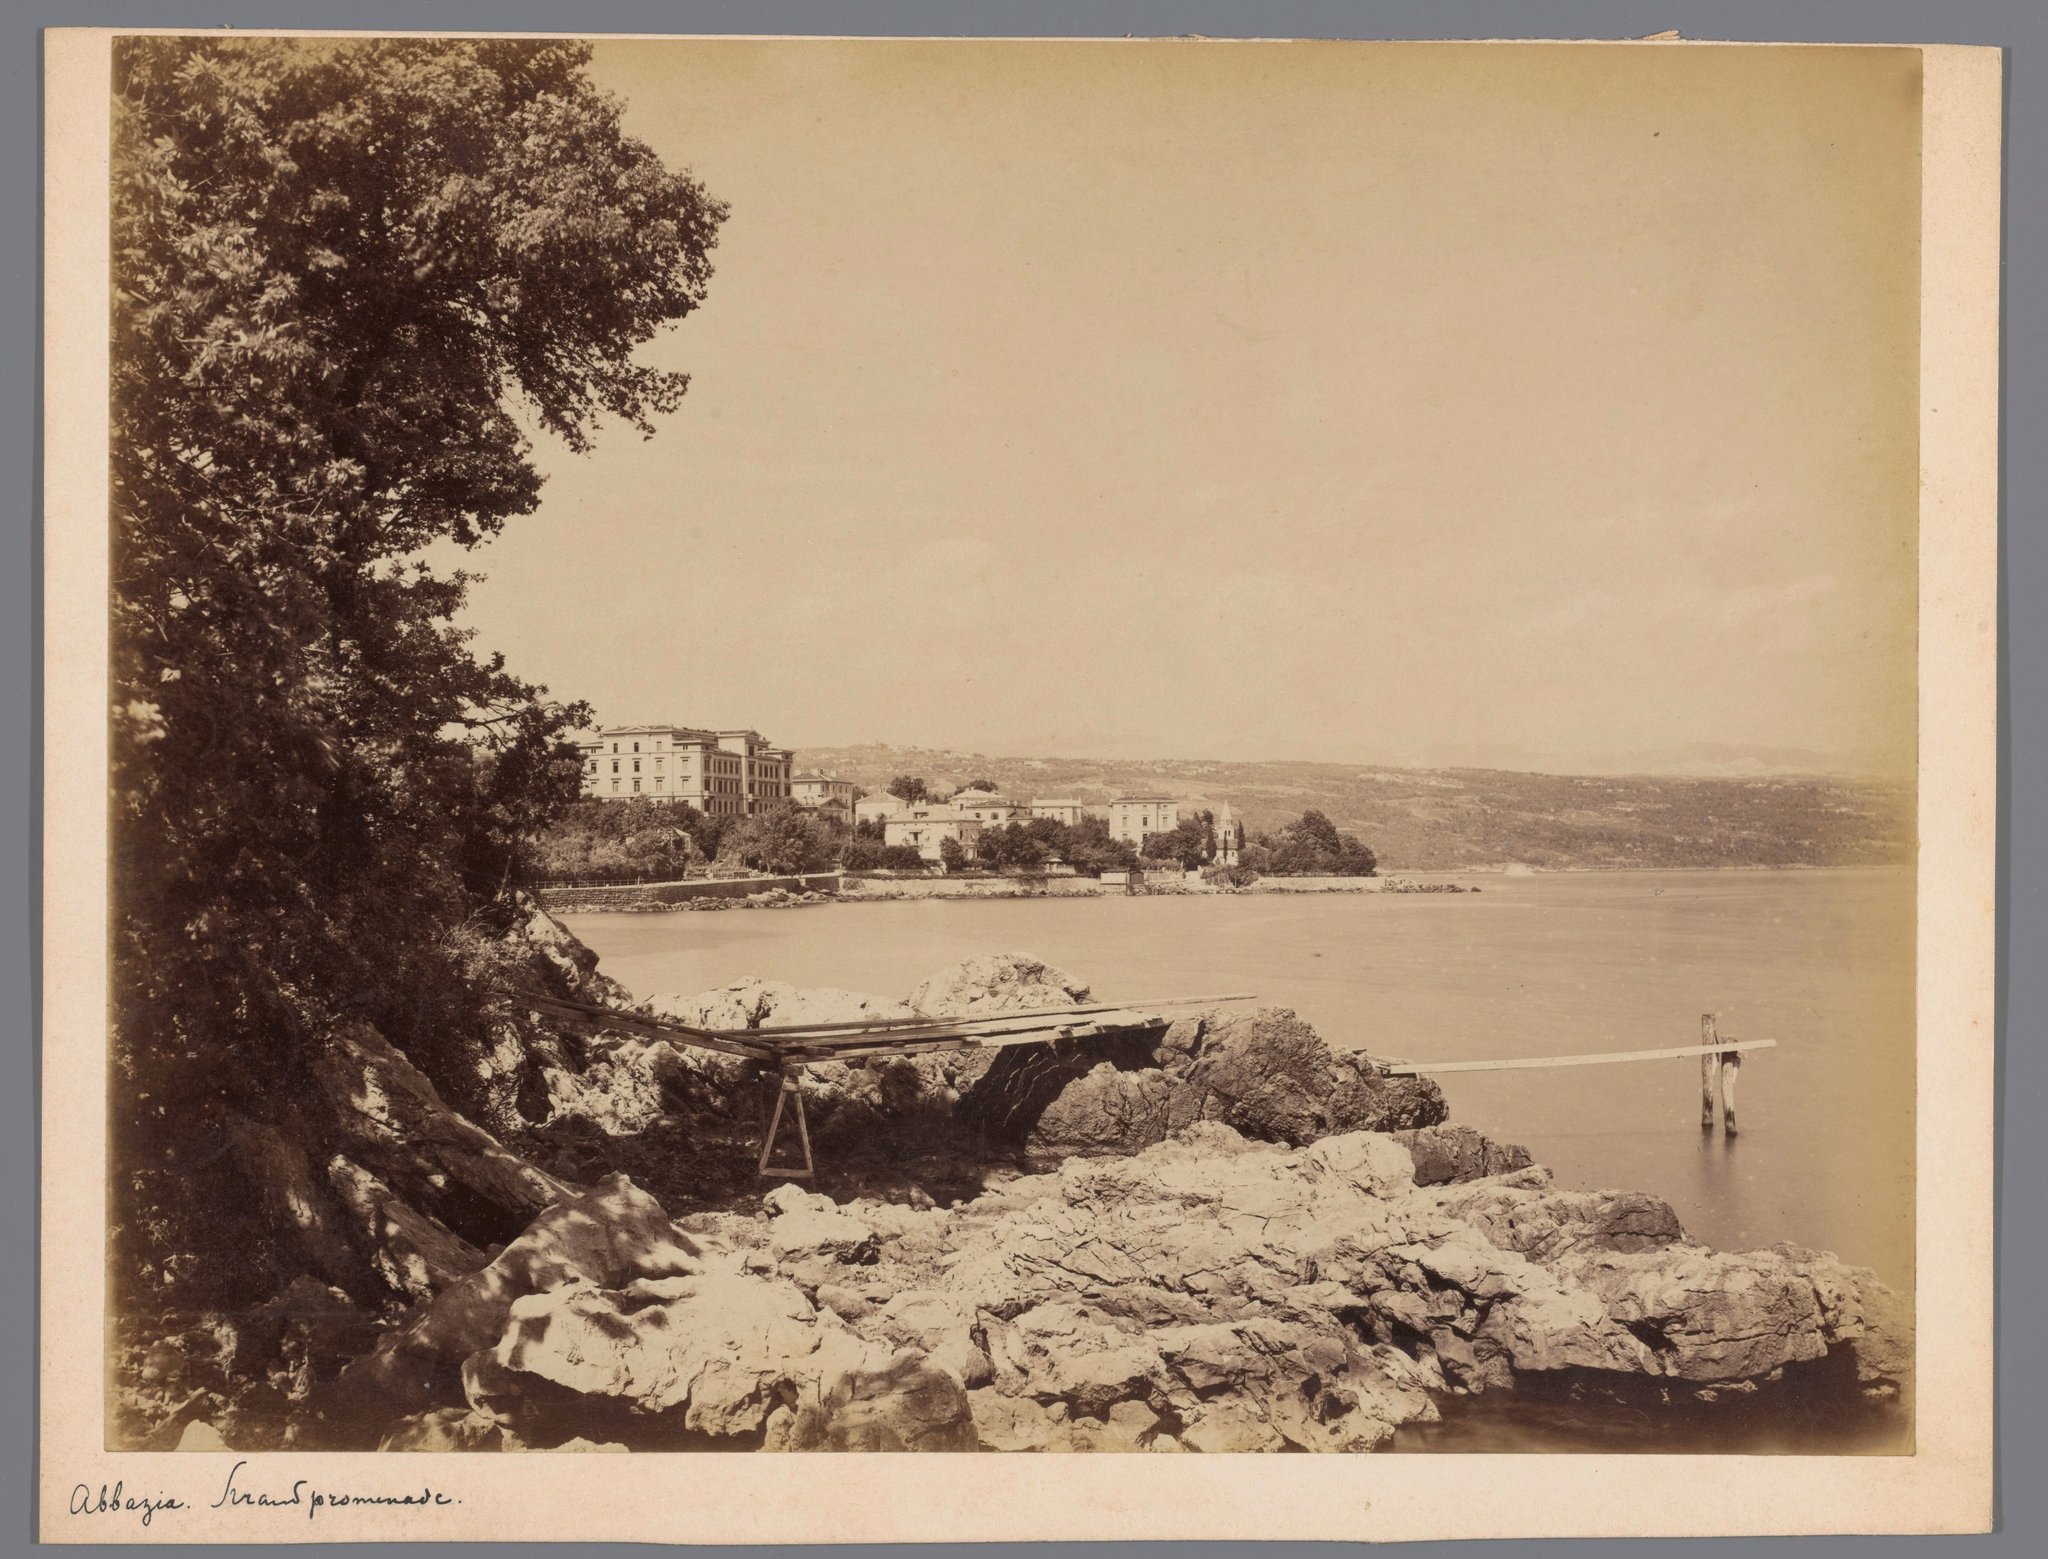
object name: photograph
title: Gezicht op Opatija aan de Kvarner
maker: Anonymous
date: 1860-1900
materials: cardboard, paper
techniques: albumen print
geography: opatija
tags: city-view in general; 'veduta', ocean